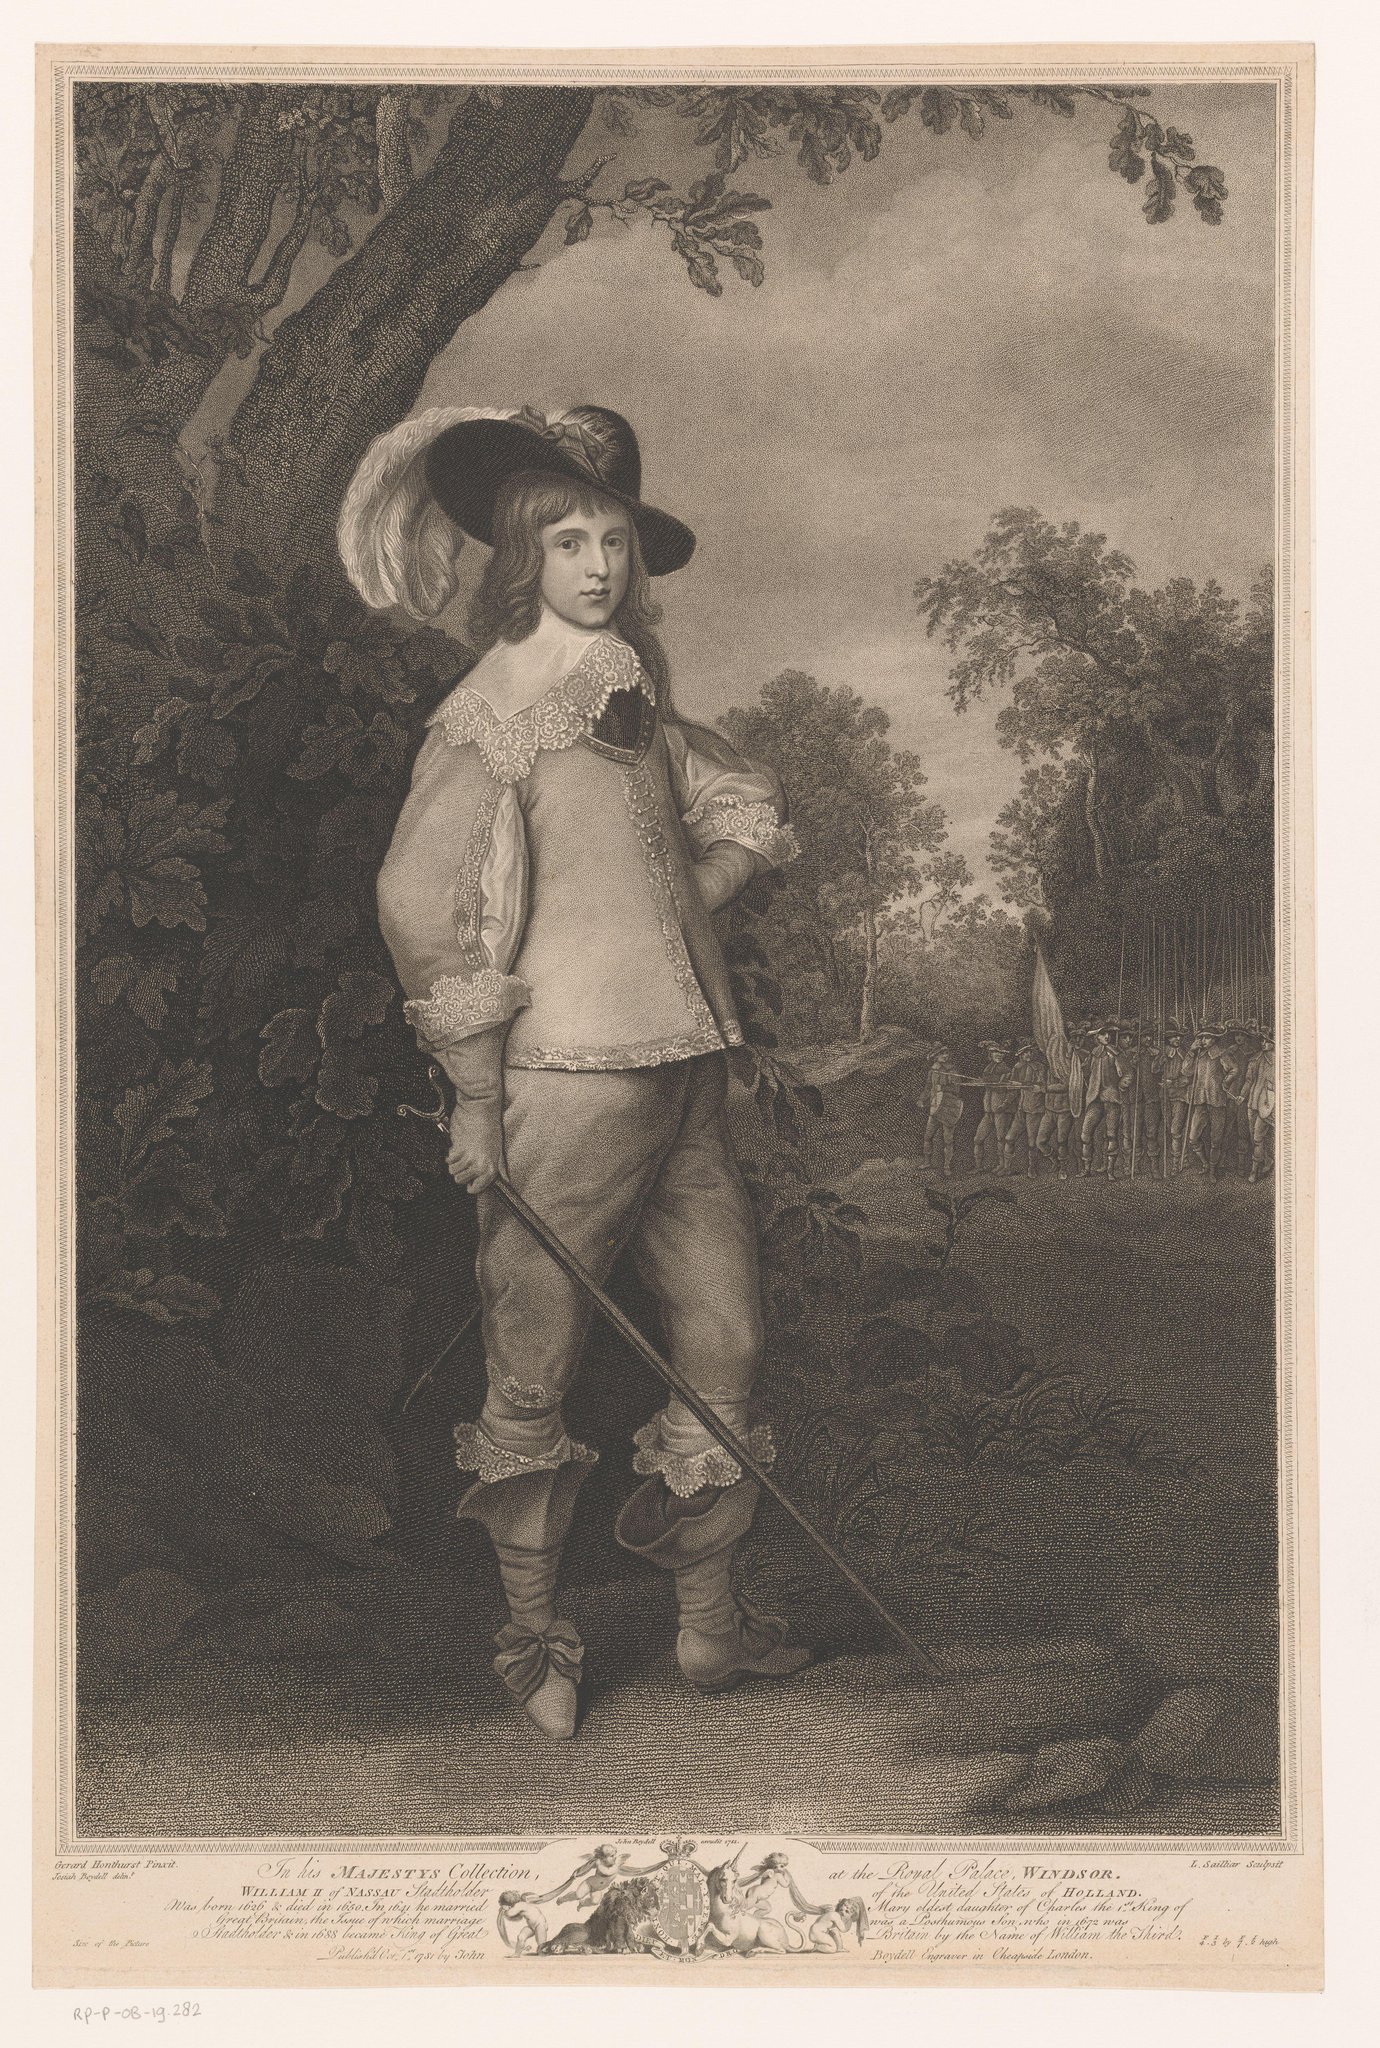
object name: print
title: Portret van Willem II van Oranje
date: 1710-1781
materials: paper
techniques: etching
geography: london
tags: william ii (prince of orange), army 'en route', historical persons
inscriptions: collector's mark: Lugt 963